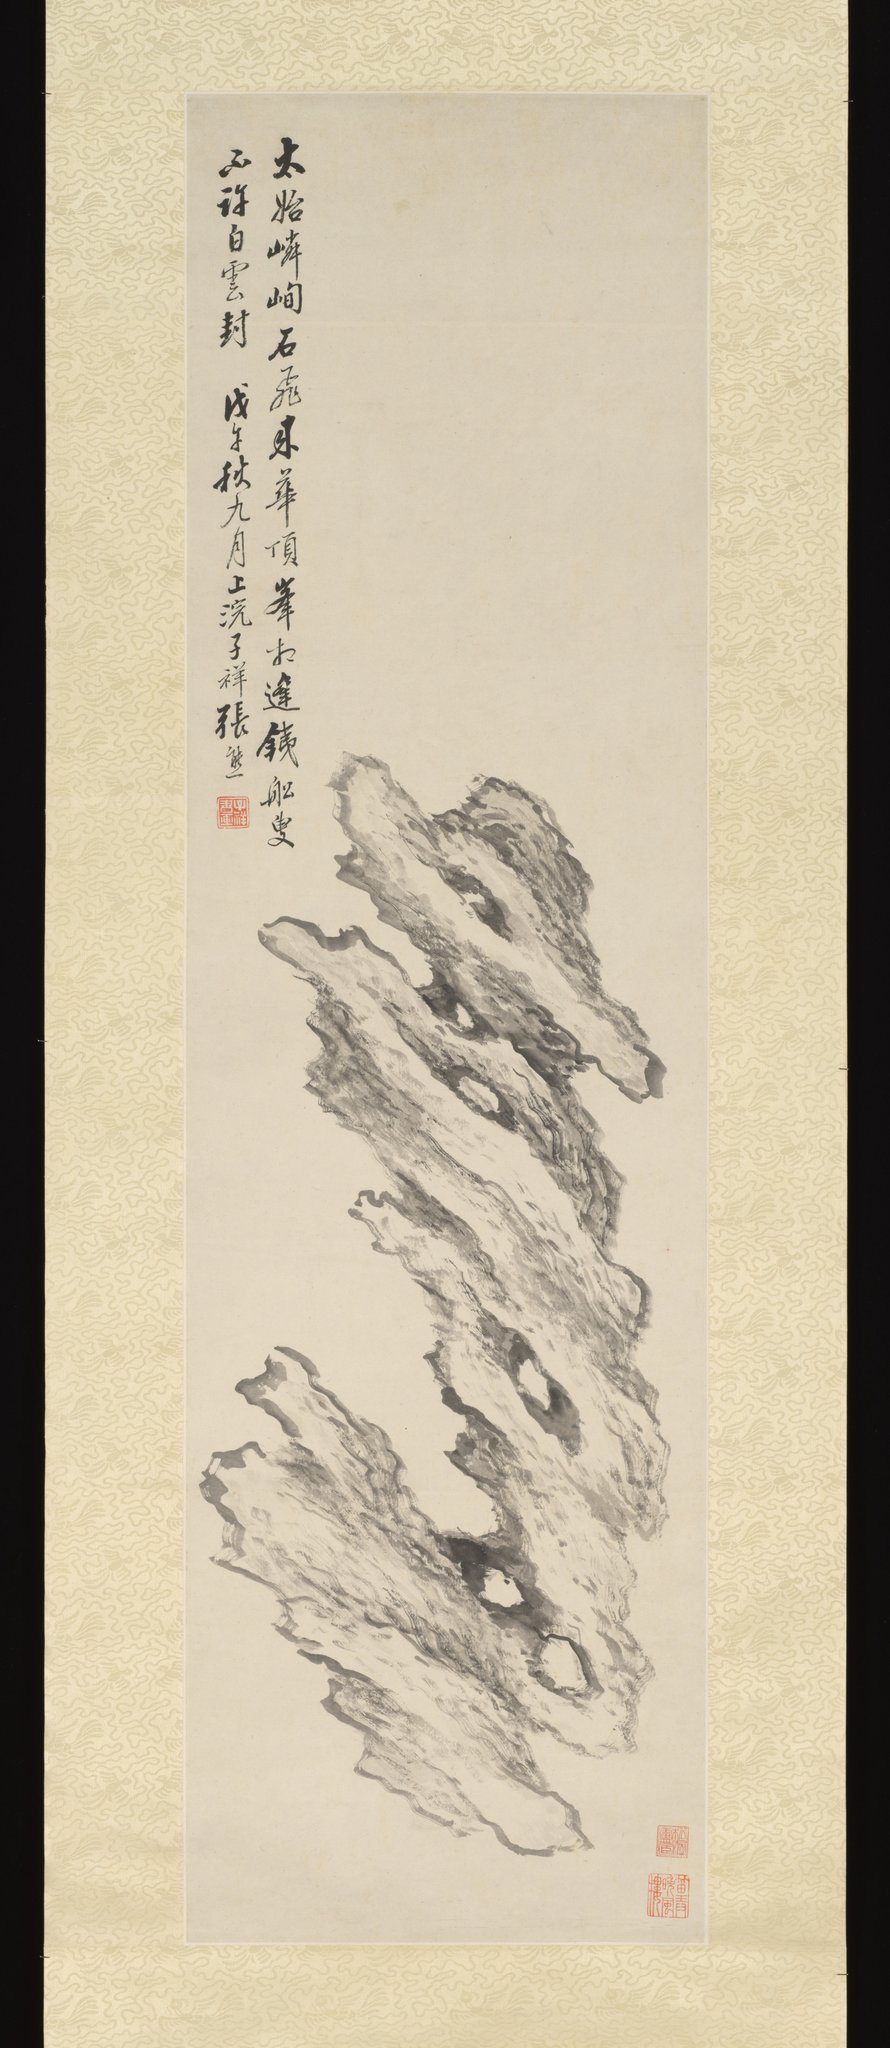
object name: hanging scroll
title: Spiritual Stone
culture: chinese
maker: zhang xiong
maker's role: artist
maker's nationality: chinese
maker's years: 1803-1886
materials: ink, paper